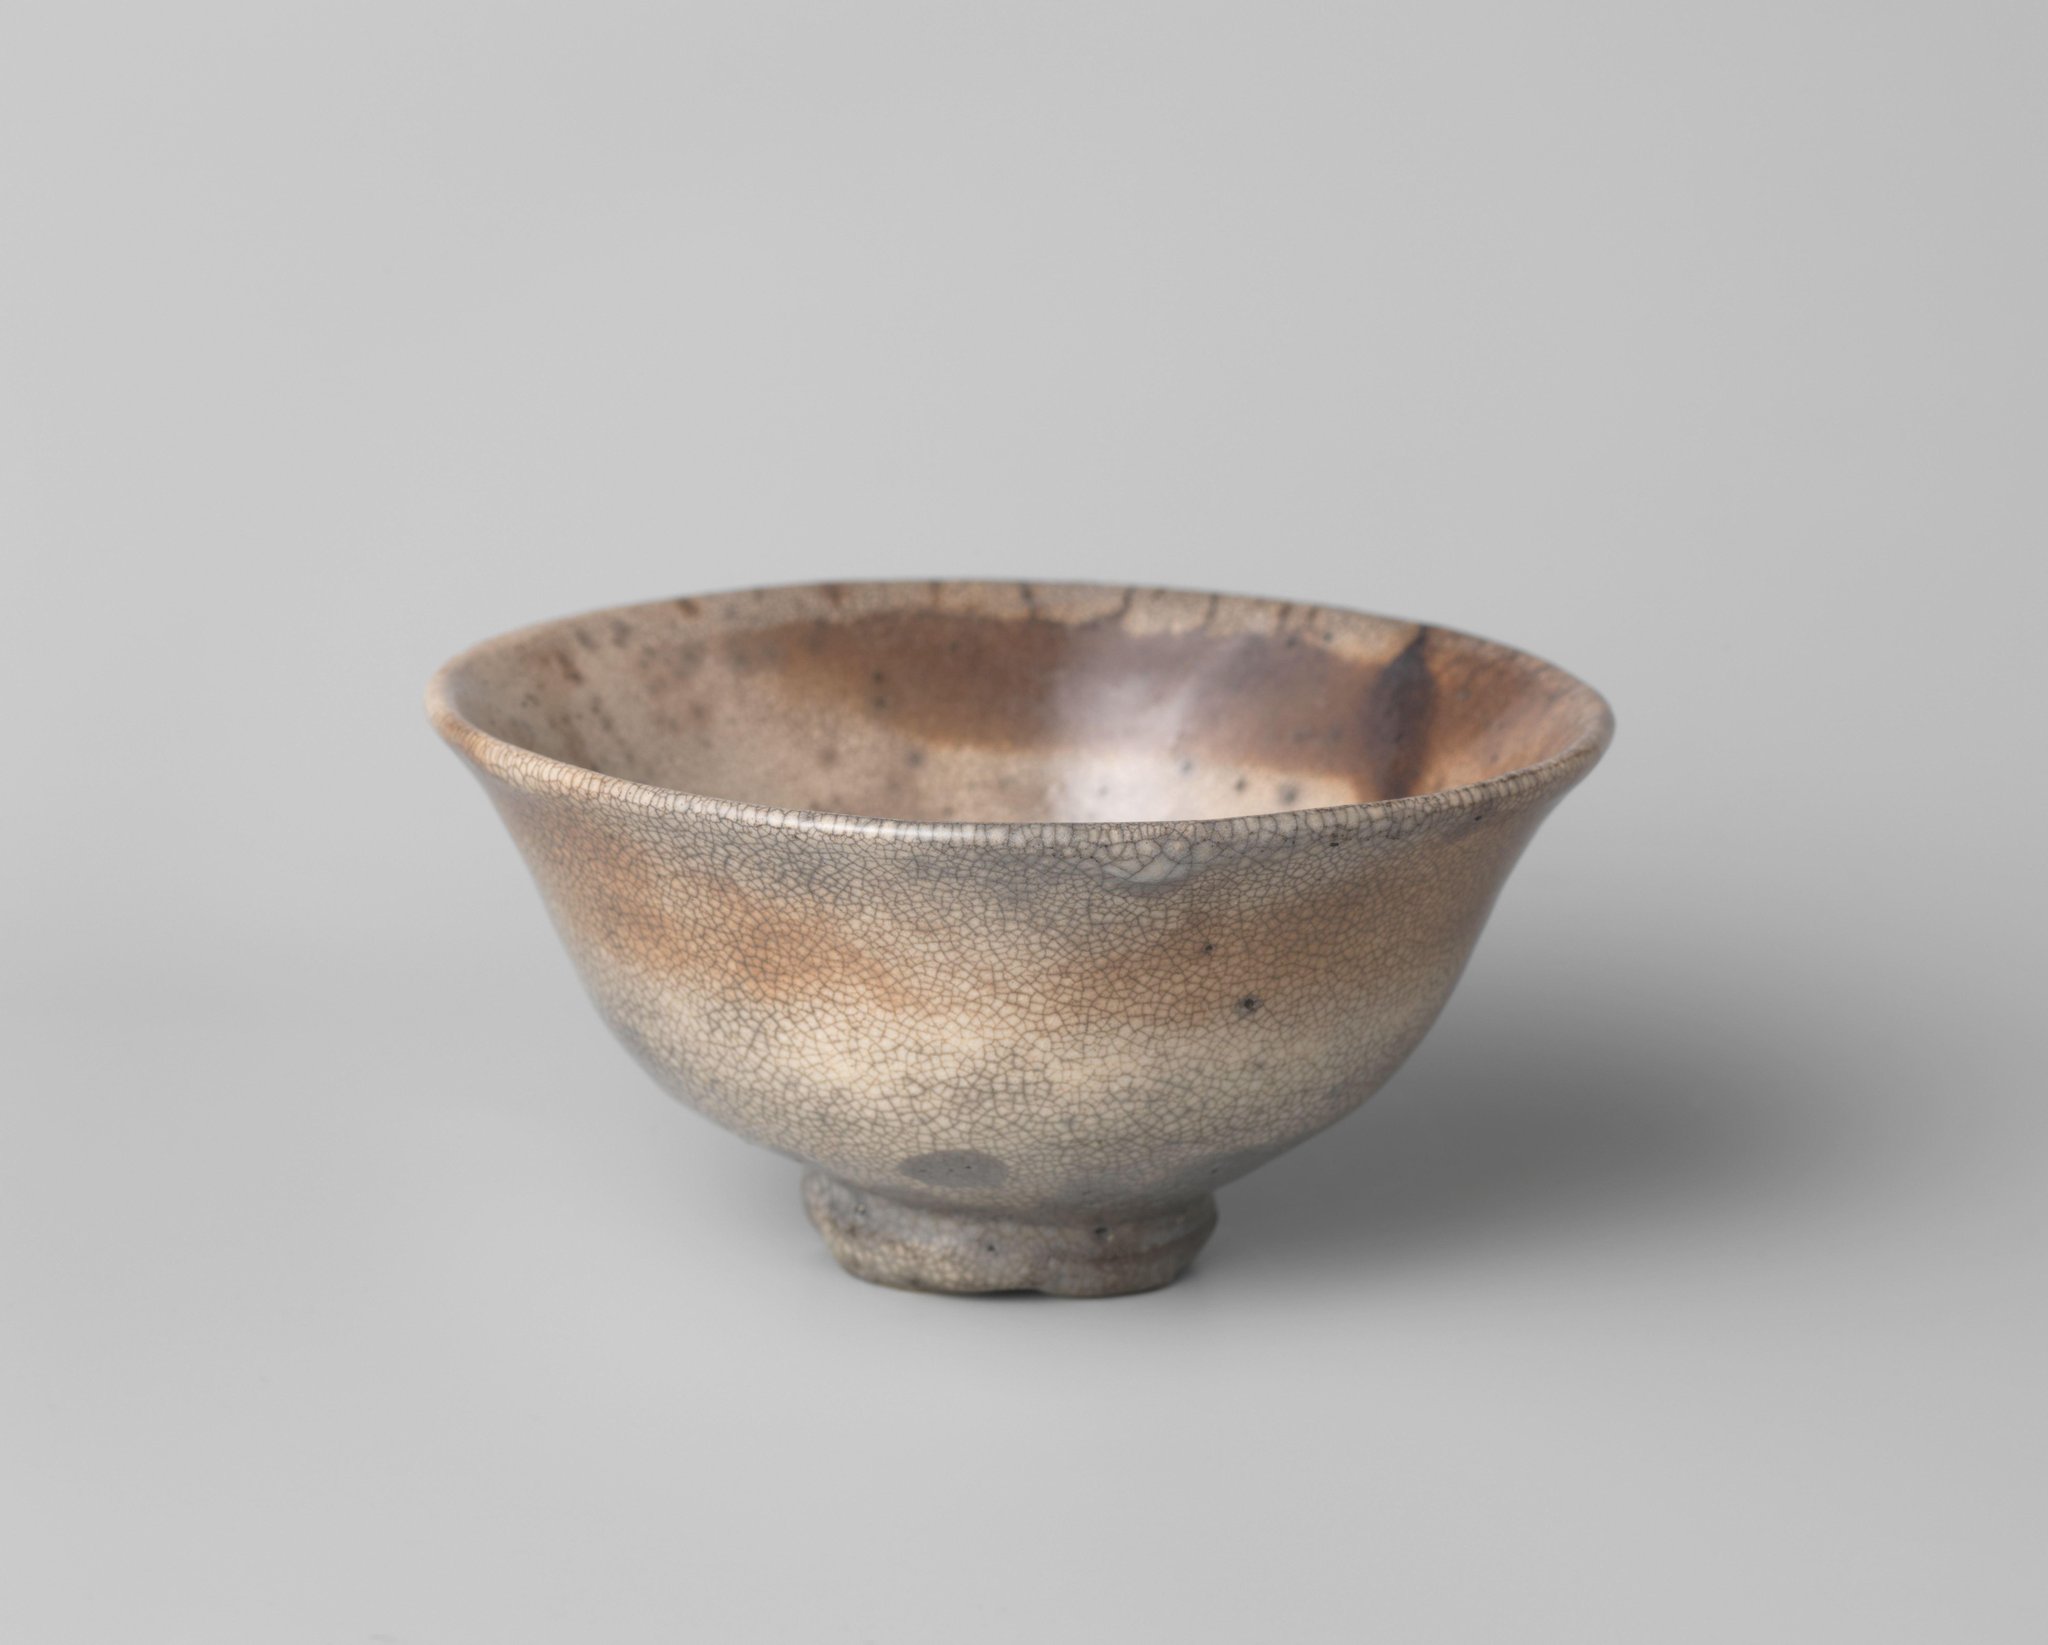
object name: bowl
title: Bowl with a greyish brown spotted cream glaze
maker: Anonymous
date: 1600-1699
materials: glaze, stoneware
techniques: firing, turning, vitrification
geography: korea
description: Kom van steengoed, bedekt met een gecraqueleerd crémekleurig glazuur met grijsbruine vlekken. Vijf proenen op de bodem.